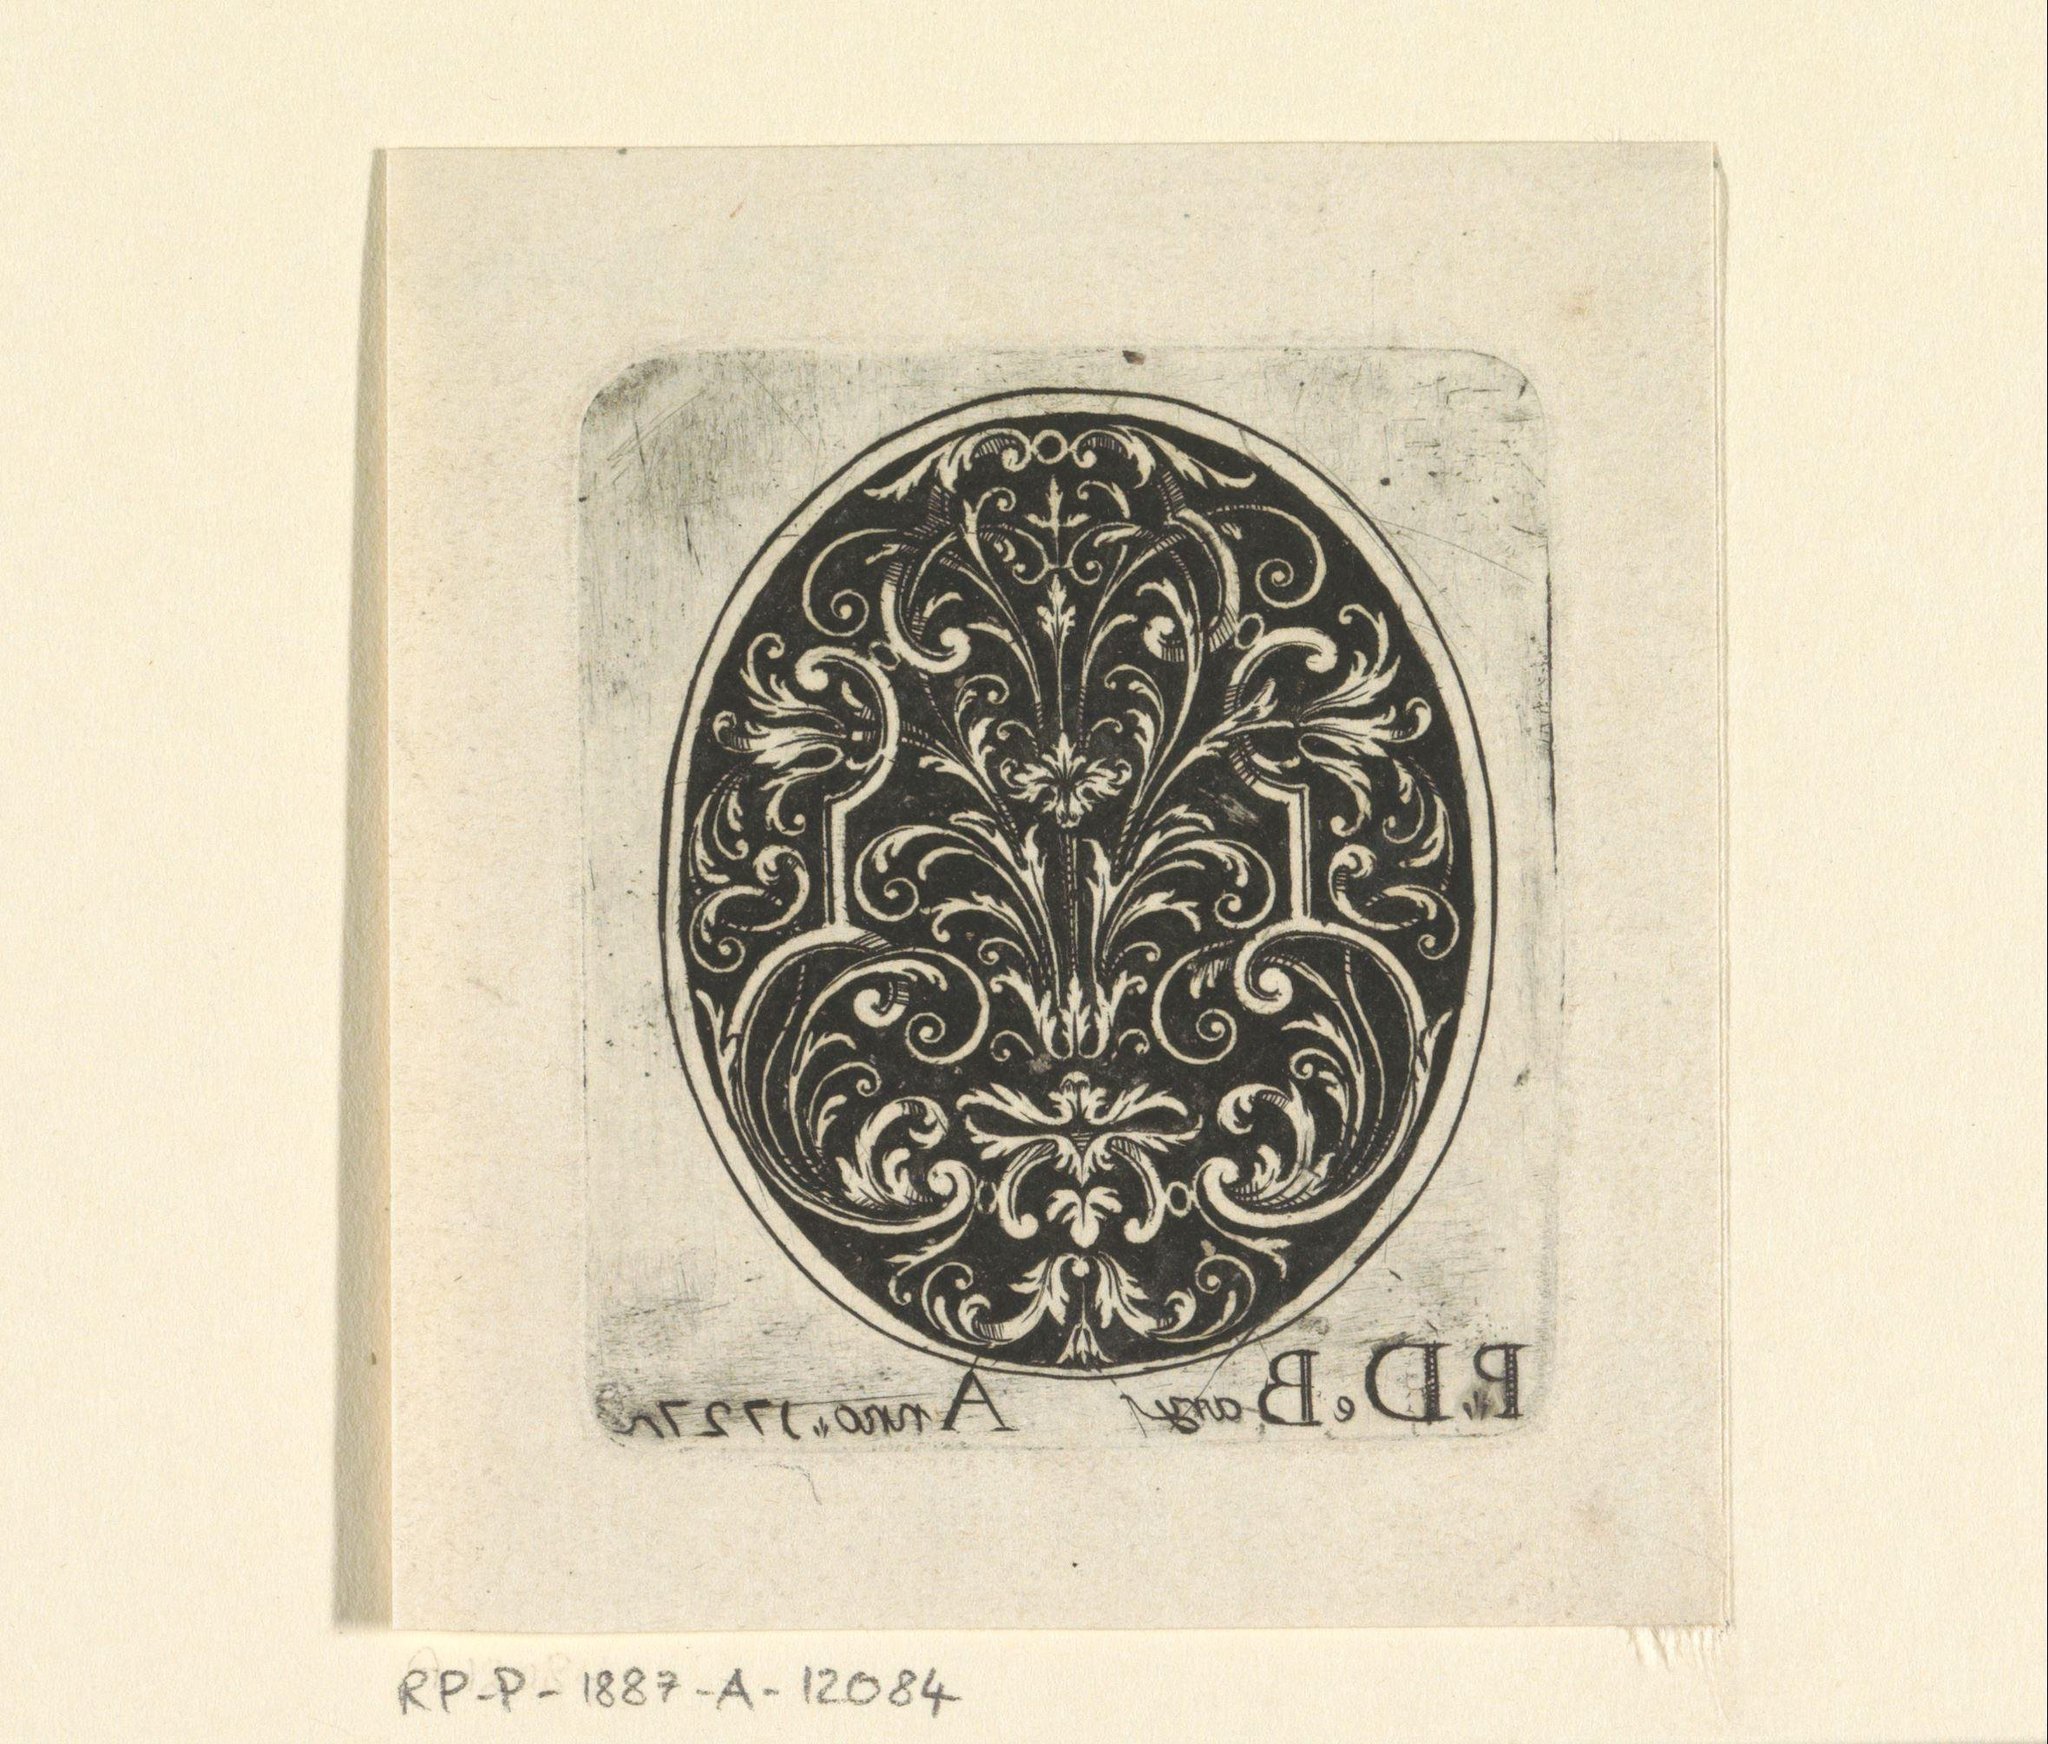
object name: ornament print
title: Ovaal ornament met florale arabesken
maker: pieter de bary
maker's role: print maker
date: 1727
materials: paper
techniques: etching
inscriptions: collector's mark: Lugt 2228